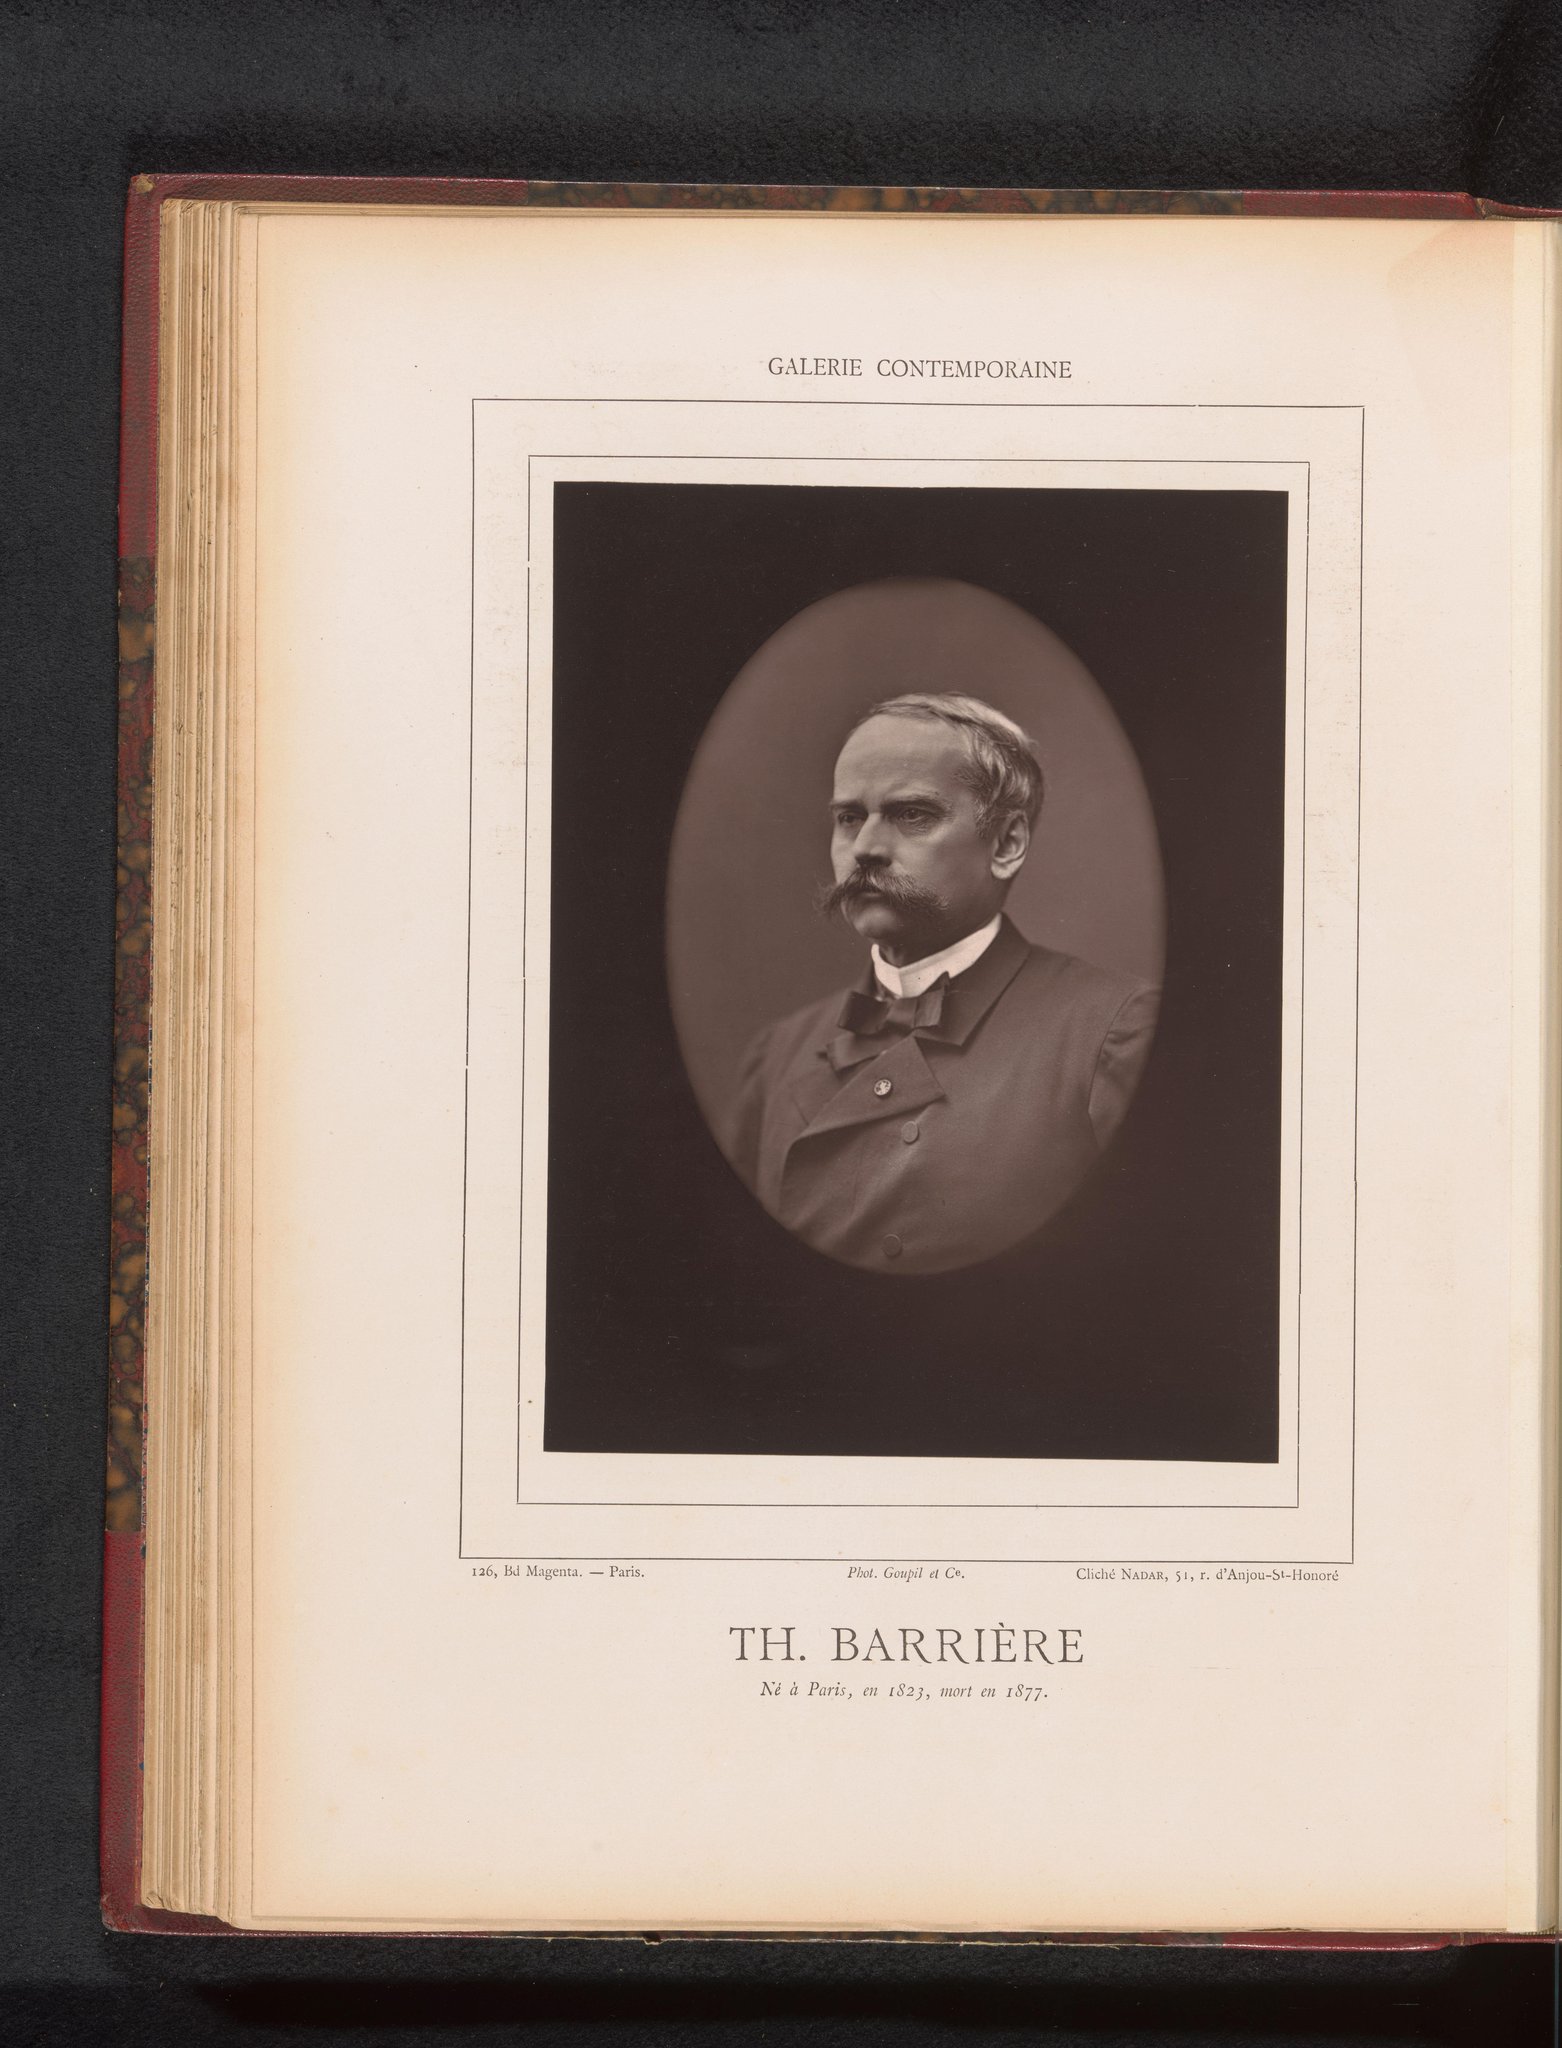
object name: page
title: Portret van Théodore Barrière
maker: félix nadar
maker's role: ballonvaarder, fotograaf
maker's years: 1820-1910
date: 1878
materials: paper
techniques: woodburytype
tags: paris, historical persons, portrait of actor, actress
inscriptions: inscription: ‘Né à Paris, en 1823, mort en 1877.’